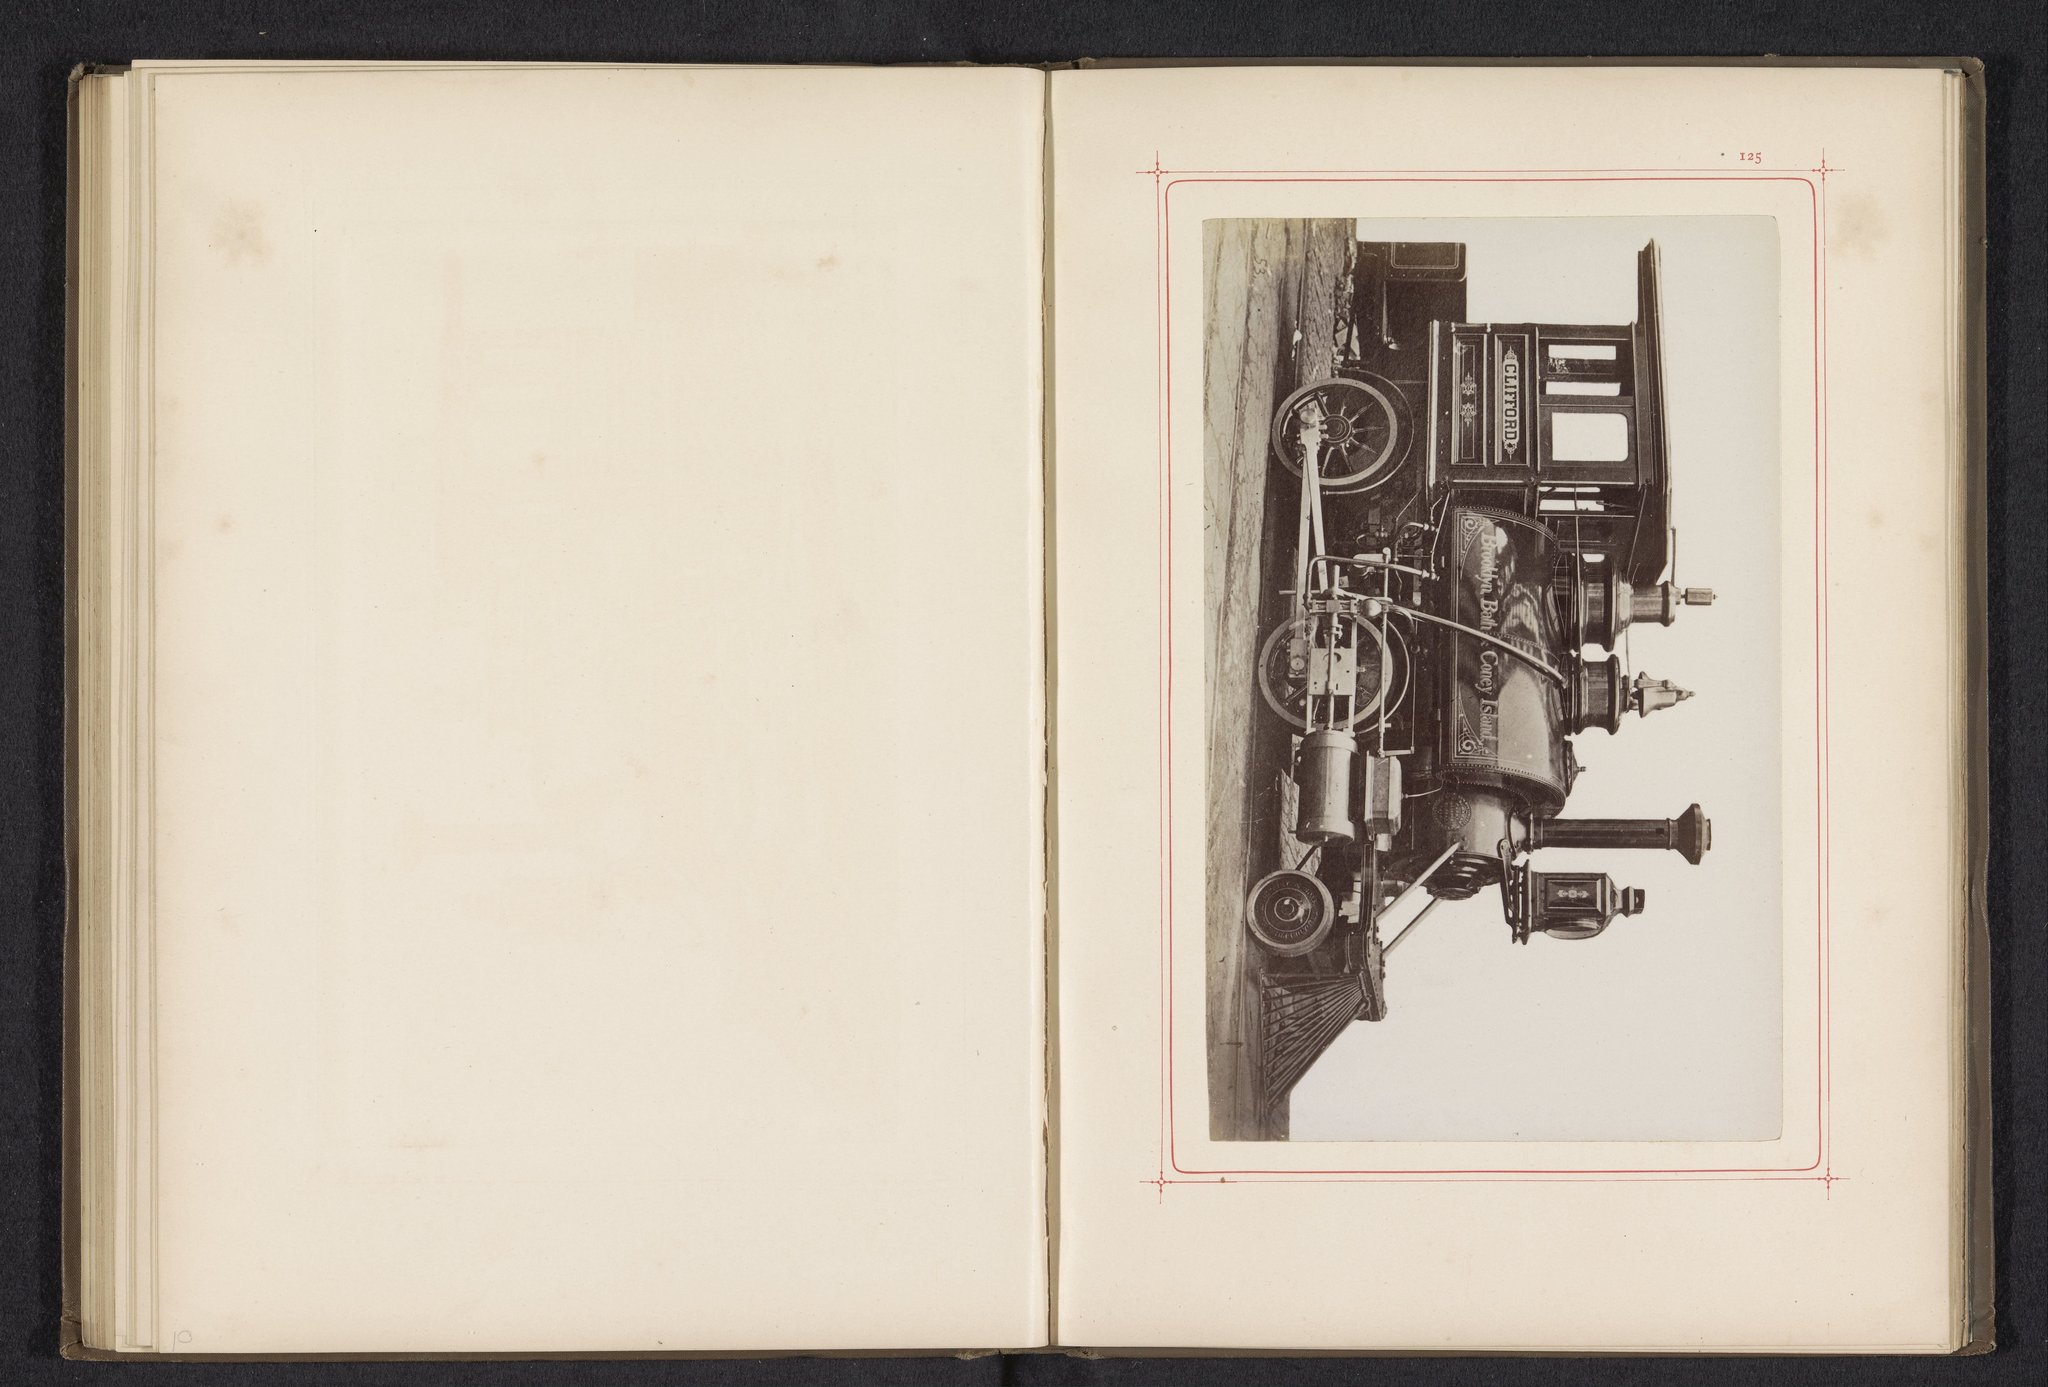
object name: page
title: Amerikaanse stoomlocomotief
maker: Anonymous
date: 1871-1881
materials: photographic support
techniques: albumen print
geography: united states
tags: steam locomotive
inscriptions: number: ‘53’